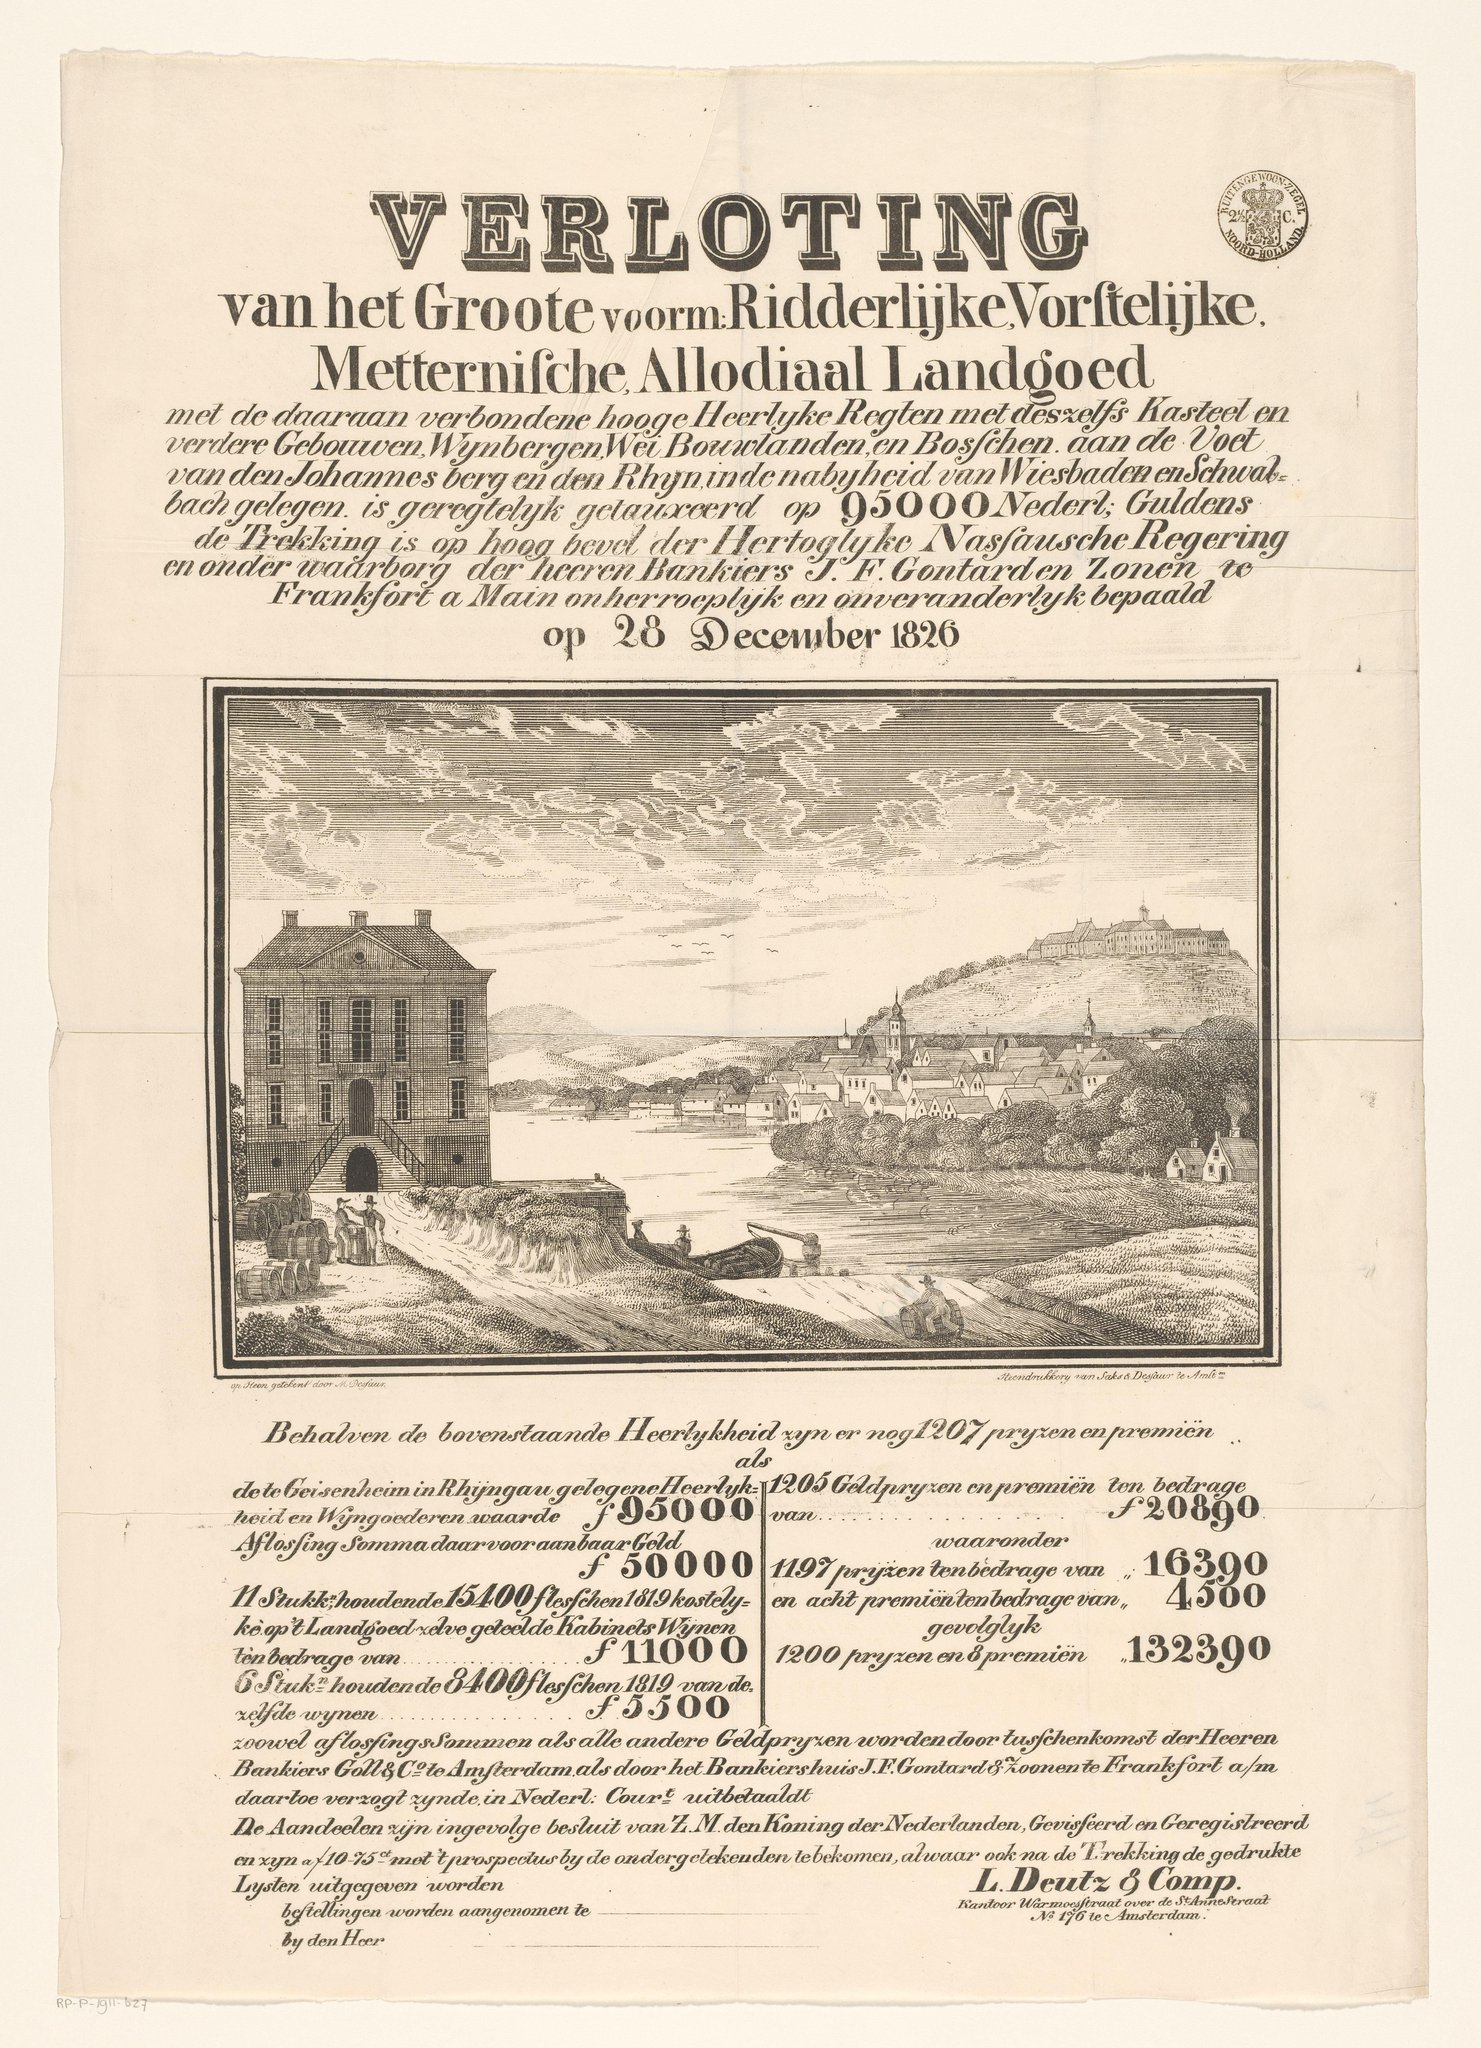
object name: print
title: Landgoed aan de Rijn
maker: morris jacob dessaur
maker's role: print maker, printer, publisher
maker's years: 1799-1876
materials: paper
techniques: lithograph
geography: amsterdam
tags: country-house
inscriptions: collector's mark: Lugt 2228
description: Een landgoed gelegen aan de Rijn nabij Wiesbaden. In de achtergrond aan de overzijde van de rivier ligt Schloss Johannisberg. Boven en onder de voorstelling de tekst met betrekking tot de loterij.